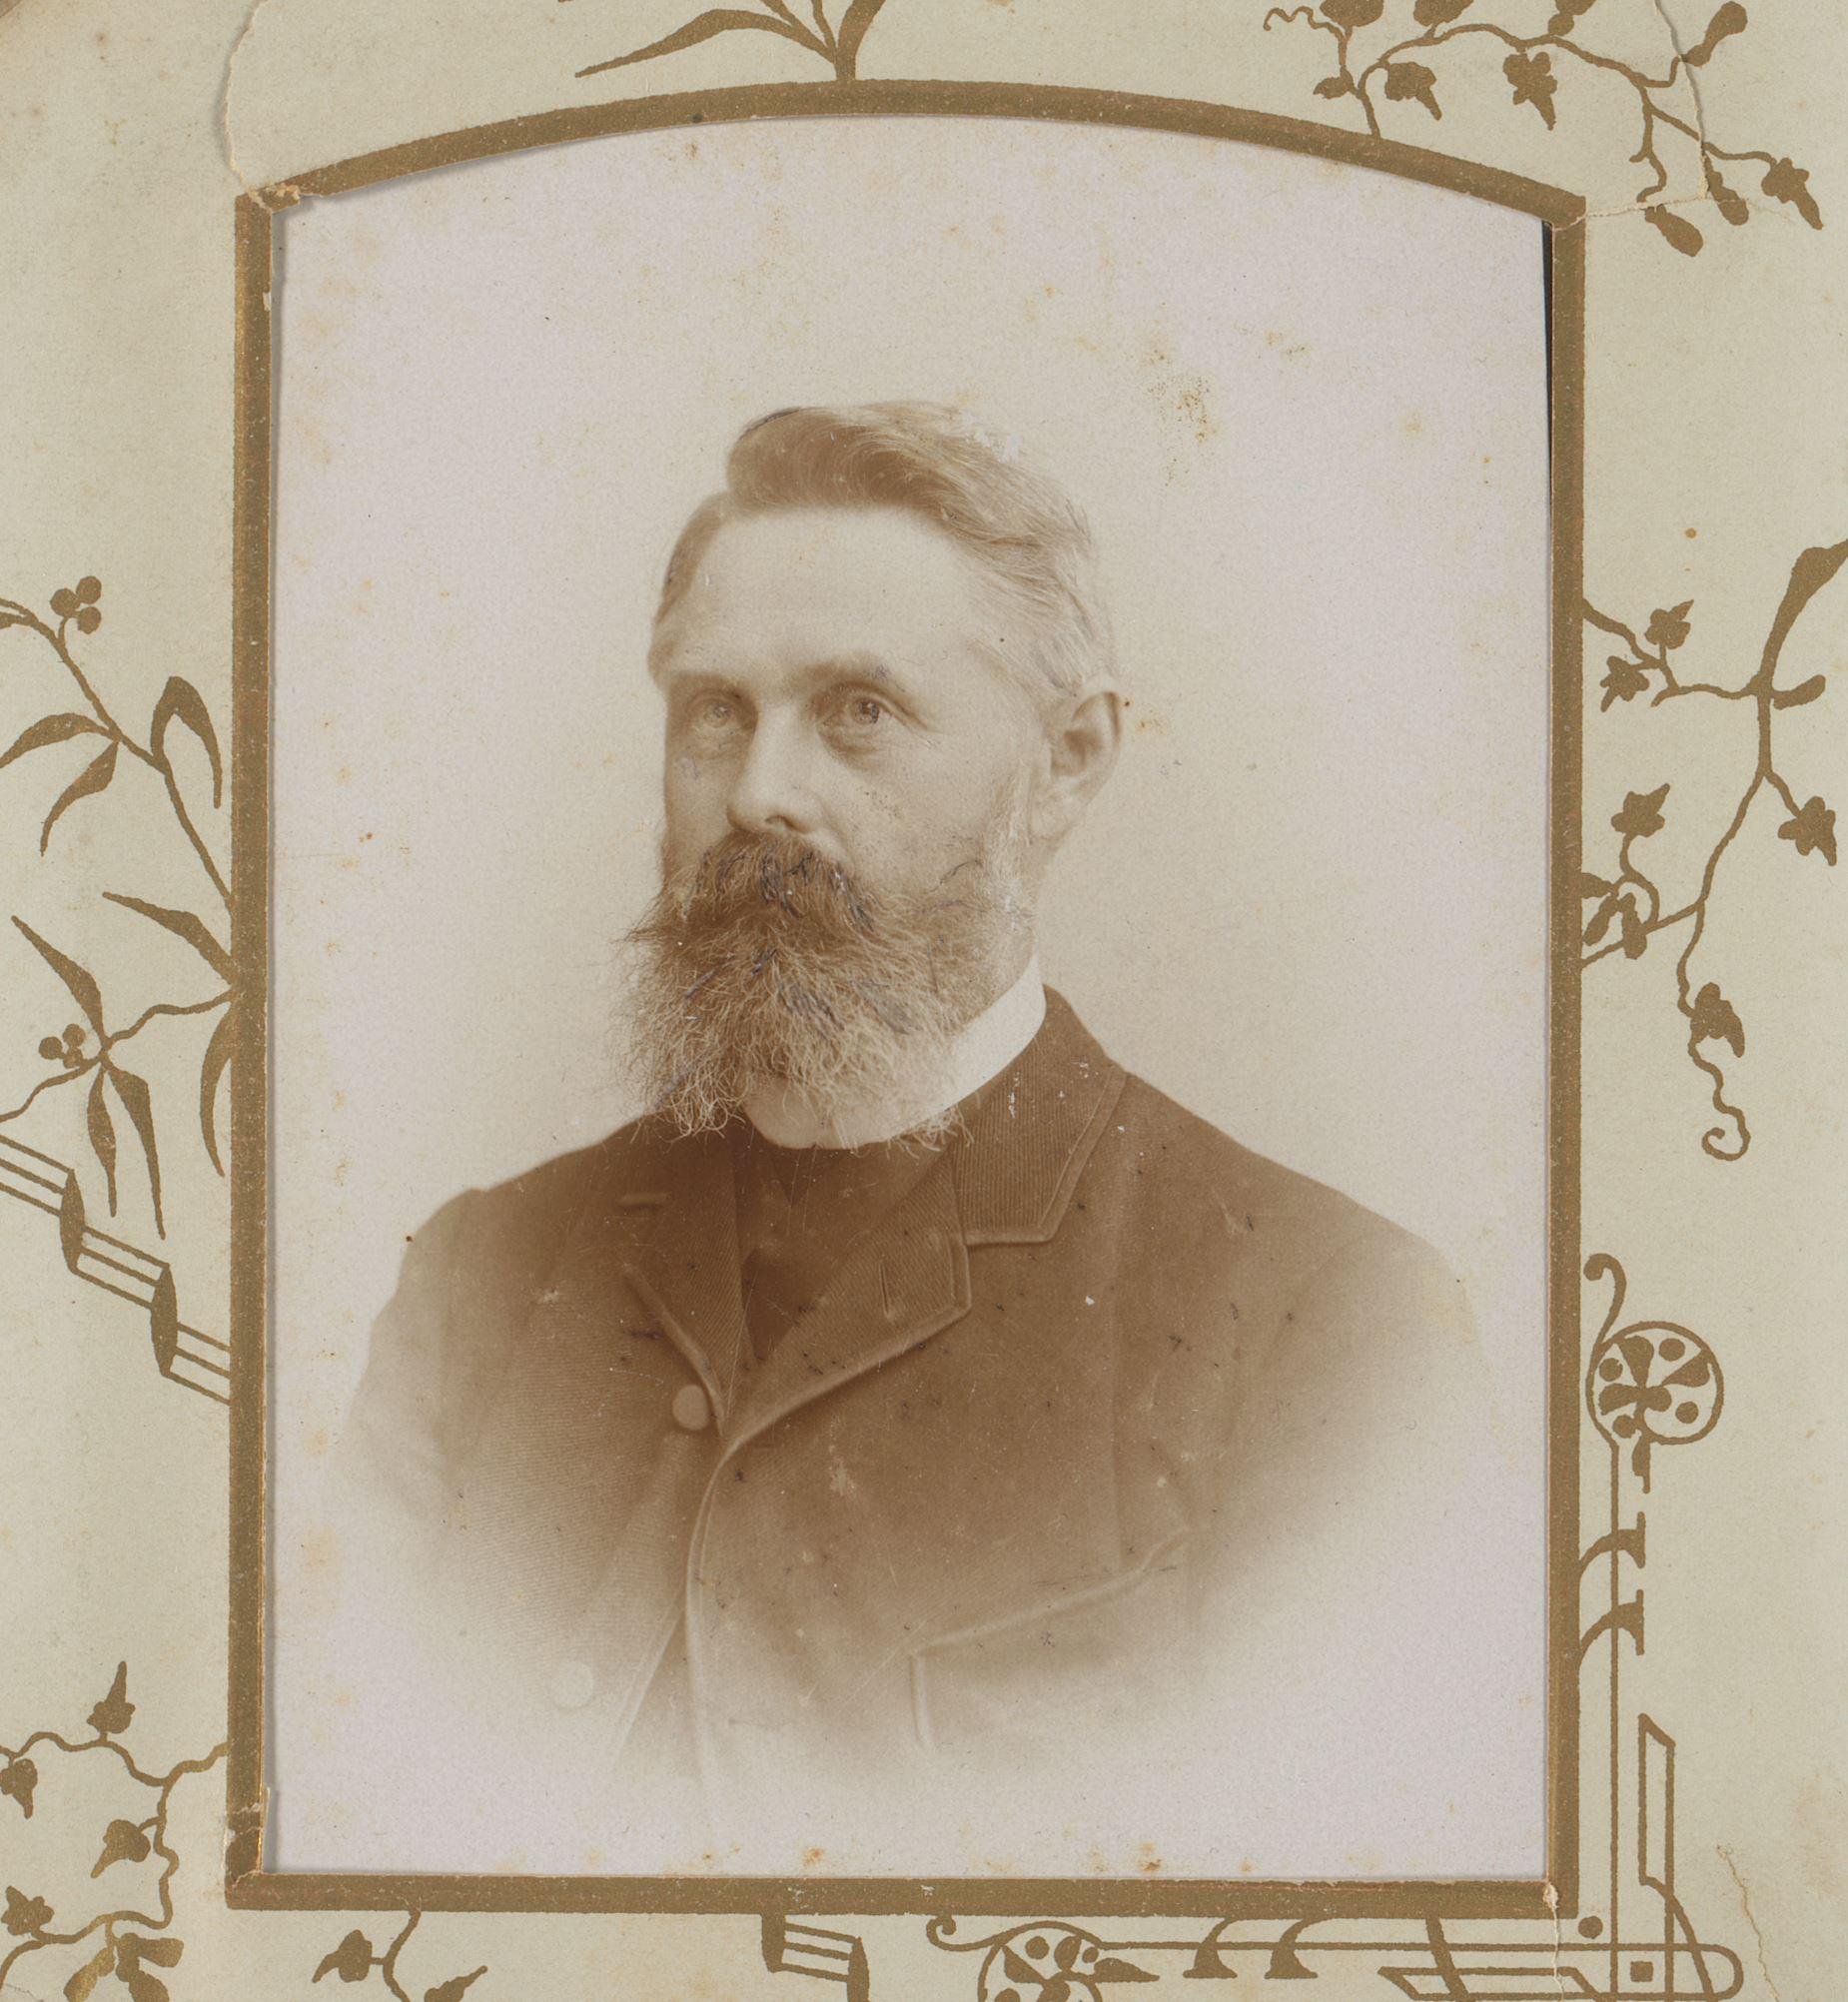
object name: cabinet photograph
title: Portret van een man met baard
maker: ernst ulbrich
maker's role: fotograaf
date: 1860-1900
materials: cardboard, photographic support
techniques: collodion silver print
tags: adult man, historical persons, beard